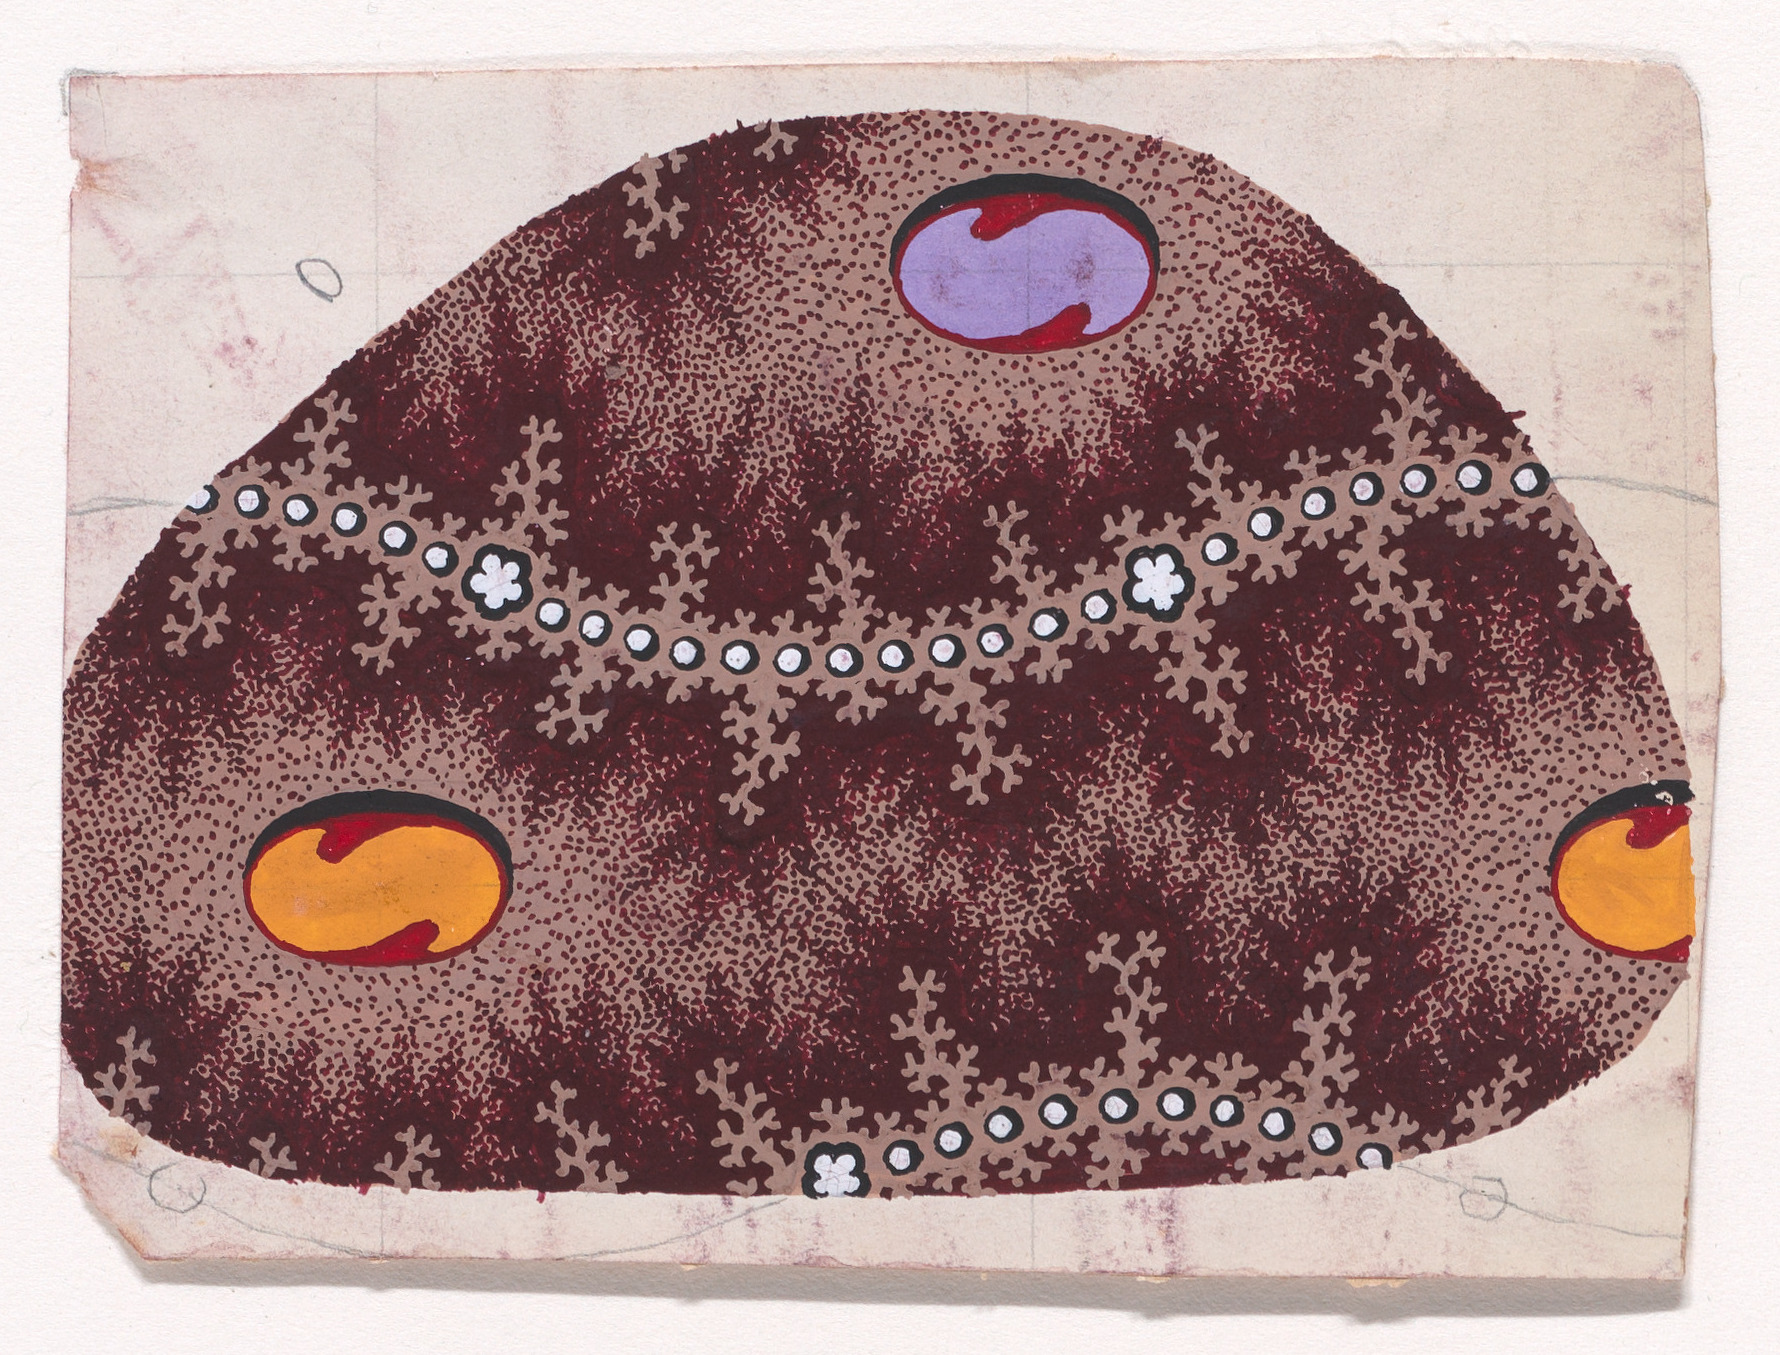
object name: drawing ornament architecture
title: Textile Design with Alternating Rows of Ellipses Containing a Stylized S-Shape Framed by Horizontal Undulating Garlands of Branches with Pearls and Rosettes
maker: anonymous, alsatian, 19th century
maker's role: artist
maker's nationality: alsatian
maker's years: 1800-1900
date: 1840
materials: gouache